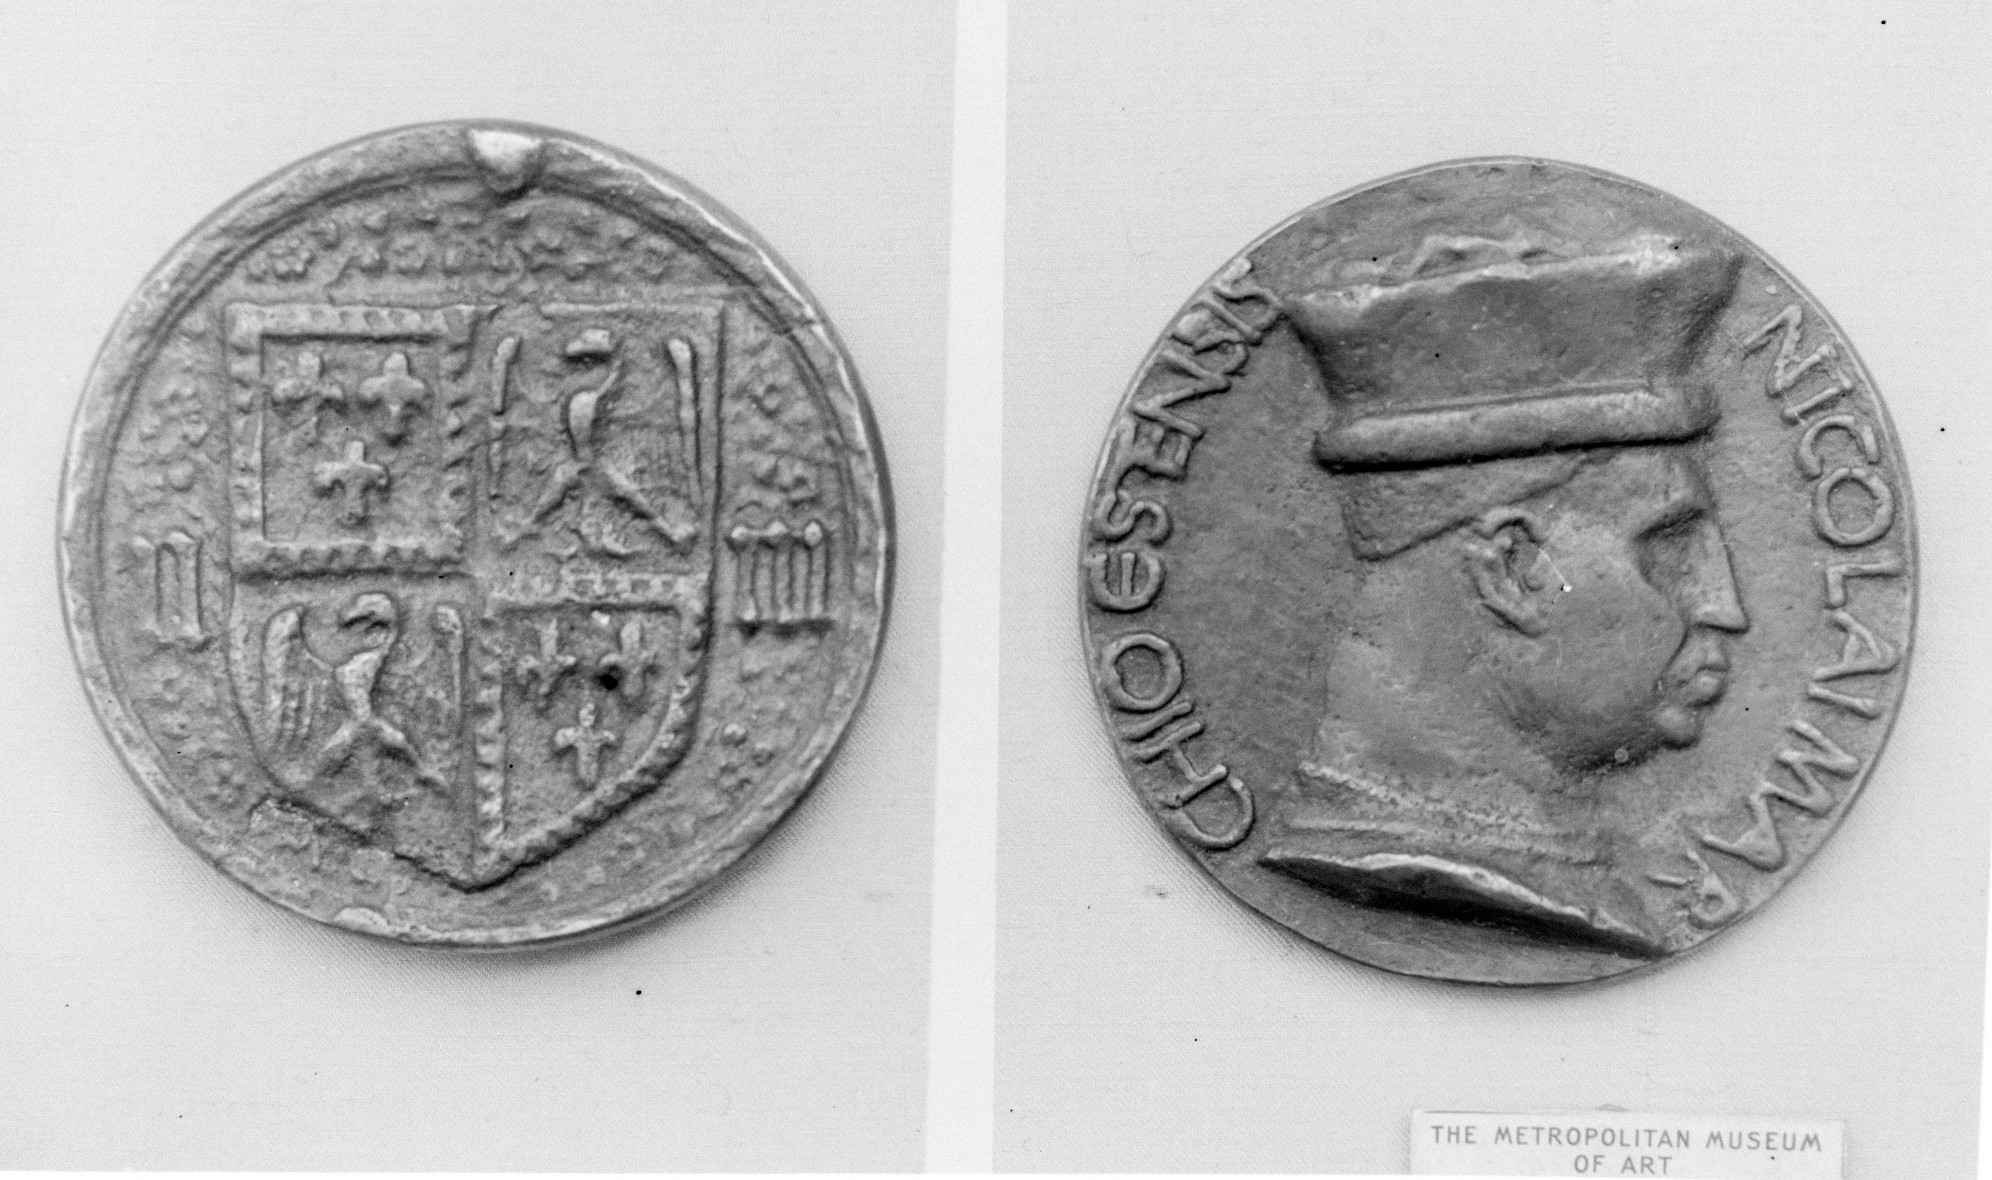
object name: medal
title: Niccolò d'Este, Marquess of Ferrara (1384?–1441)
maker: amadeo da milano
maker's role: maker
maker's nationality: italian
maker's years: 1437-1482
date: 1437-1441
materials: bronze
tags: men,profiles,coat of arms